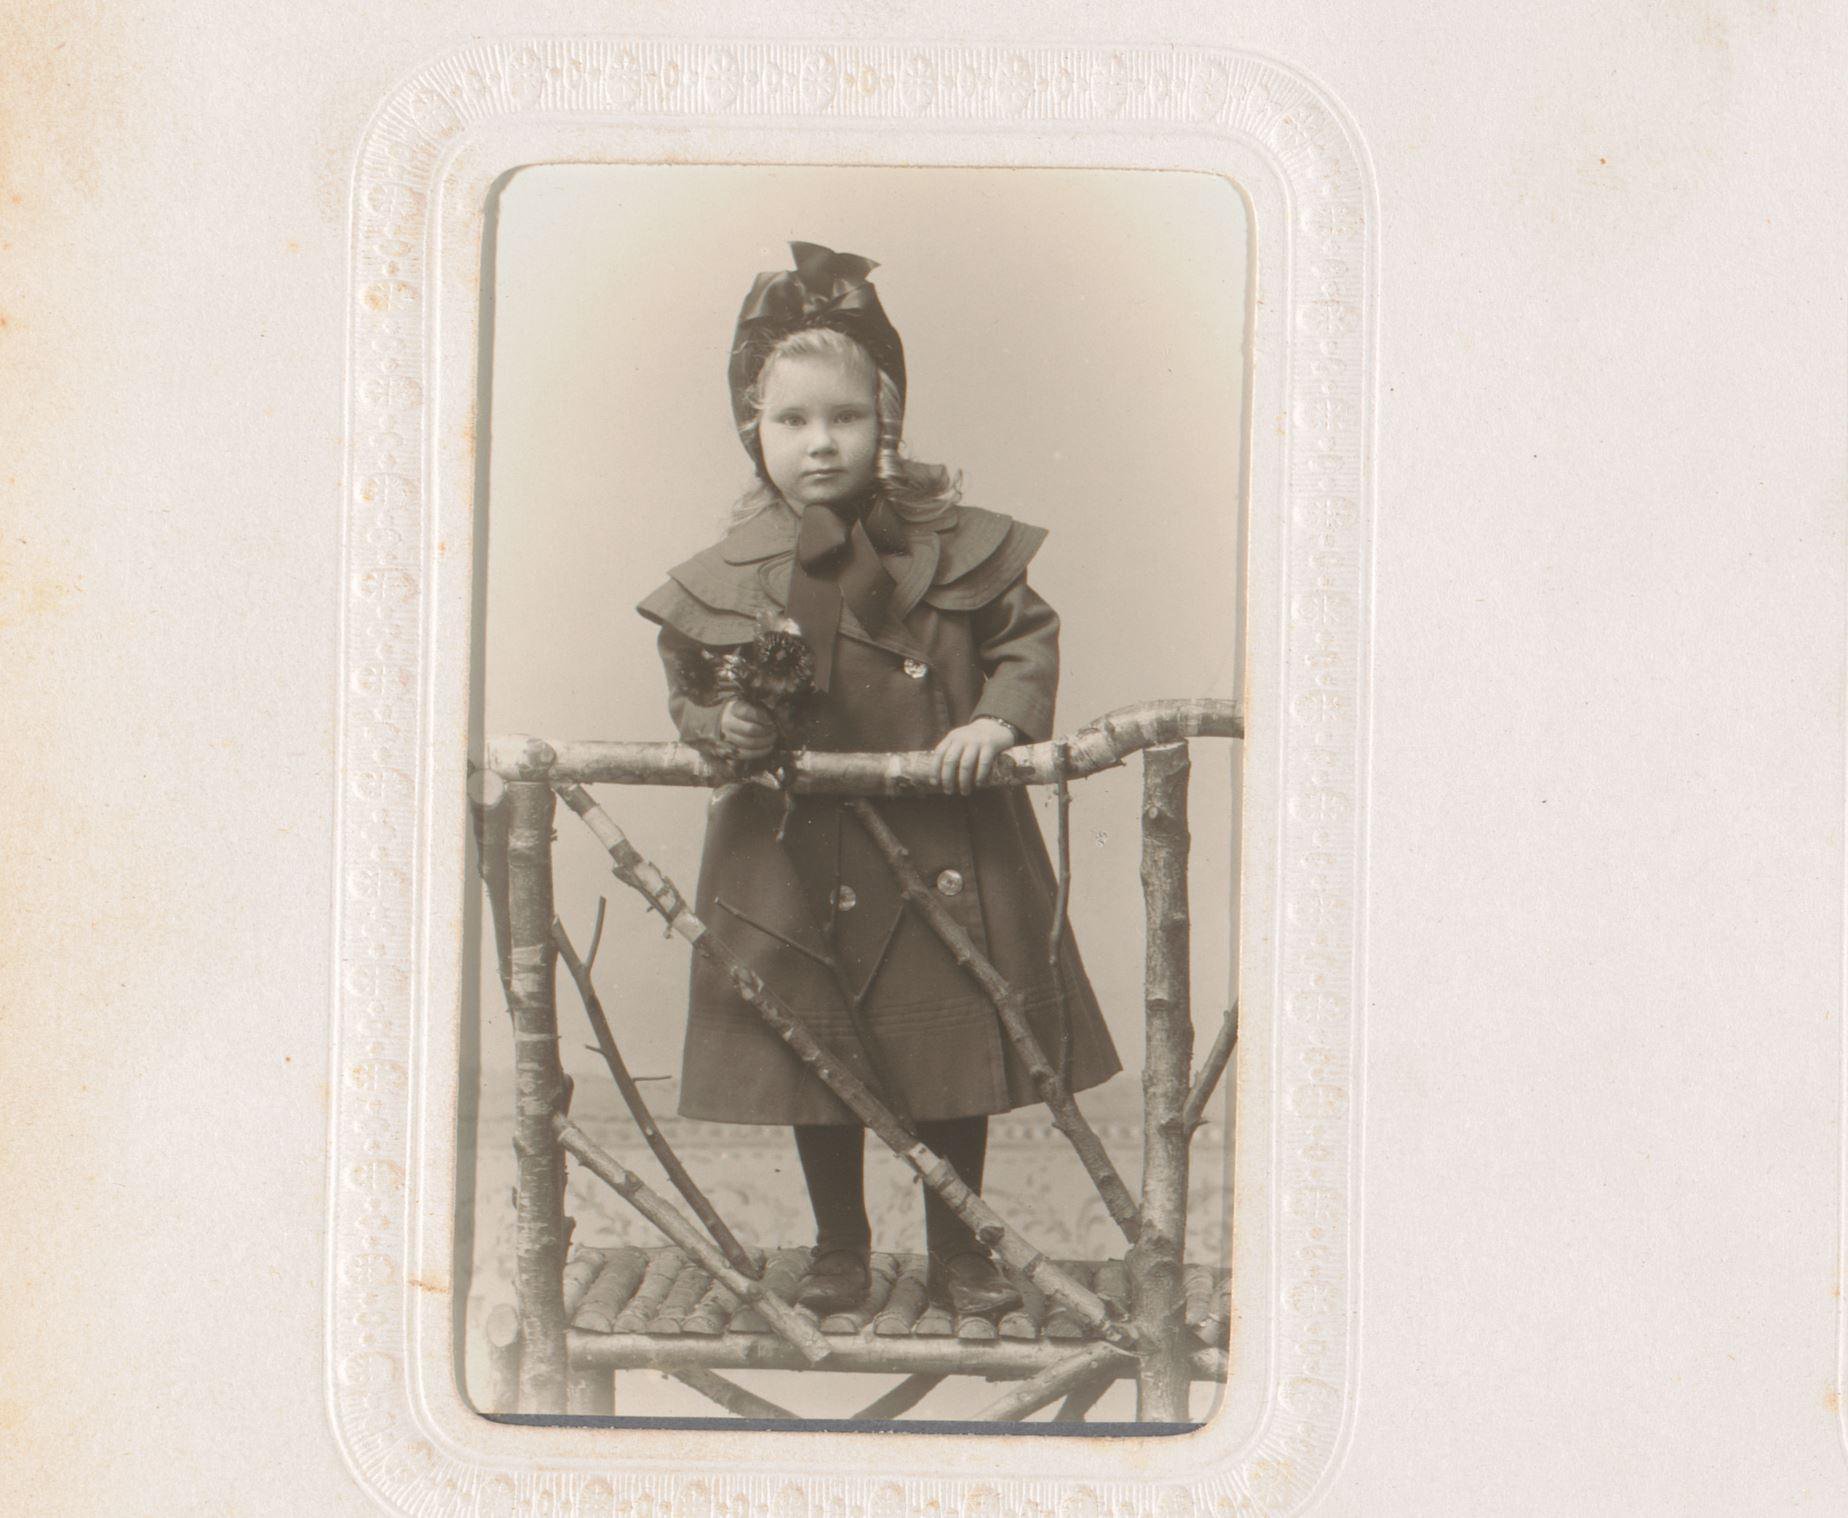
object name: carte de visite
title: Portret van Wilhelmina Antonia Waszink met muts en jas, staand achter een hek van takken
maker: henriette l. kooy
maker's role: fotograaf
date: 1903-1910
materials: cardboard, photographic support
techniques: collodion silver print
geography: hilversum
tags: historical persons - bb - woman, fence, wall, paling, toddler (female)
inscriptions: inscription: ‘Henriette L. Kooy/ Hilversum/ Bergweg.’, annotation: ‘Wilhelmina Antoni[a]/ Waszink/ geb: 7 Febr. 1900/ geph: Oct 1903/ Henri’